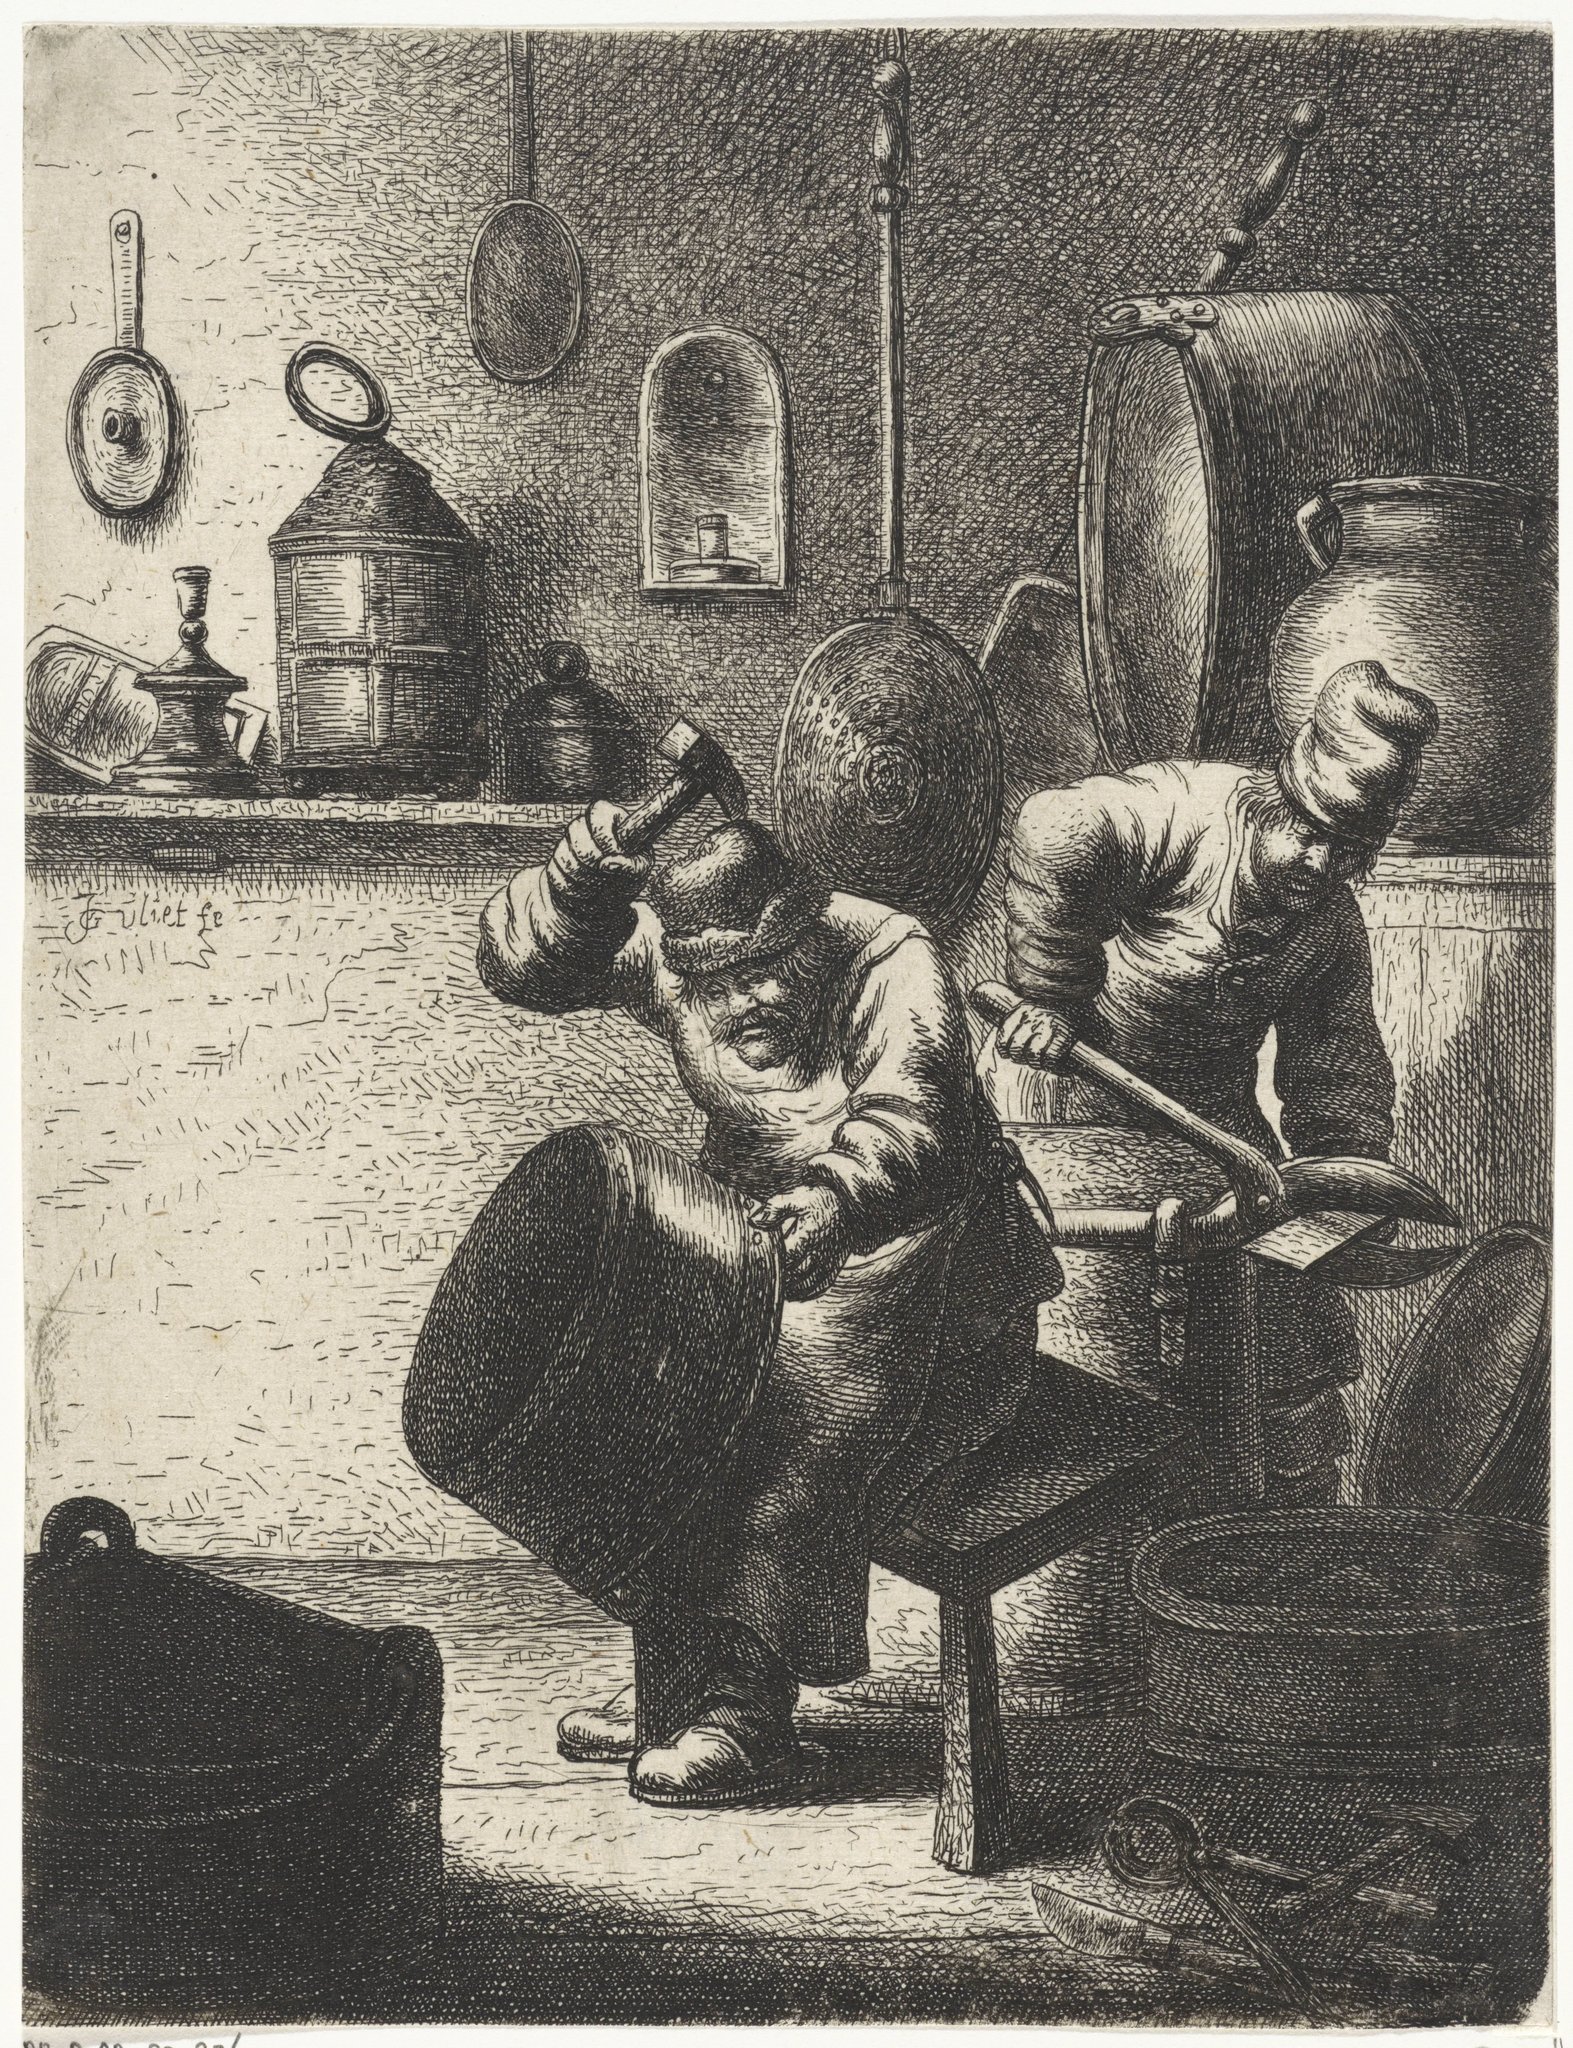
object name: print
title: Beroepen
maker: jan gillisz. van vliet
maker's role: draughtsman, painter, print maker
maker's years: 1600-1668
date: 1635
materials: paper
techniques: etching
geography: leiden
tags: coppersmith, brassworker, industries ~ metal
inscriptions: collector's mark: Lugt 240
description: Twee koperslagers in een werkplaats; een van hen hamert op een kuip, de ander snijdt een koperplaat.